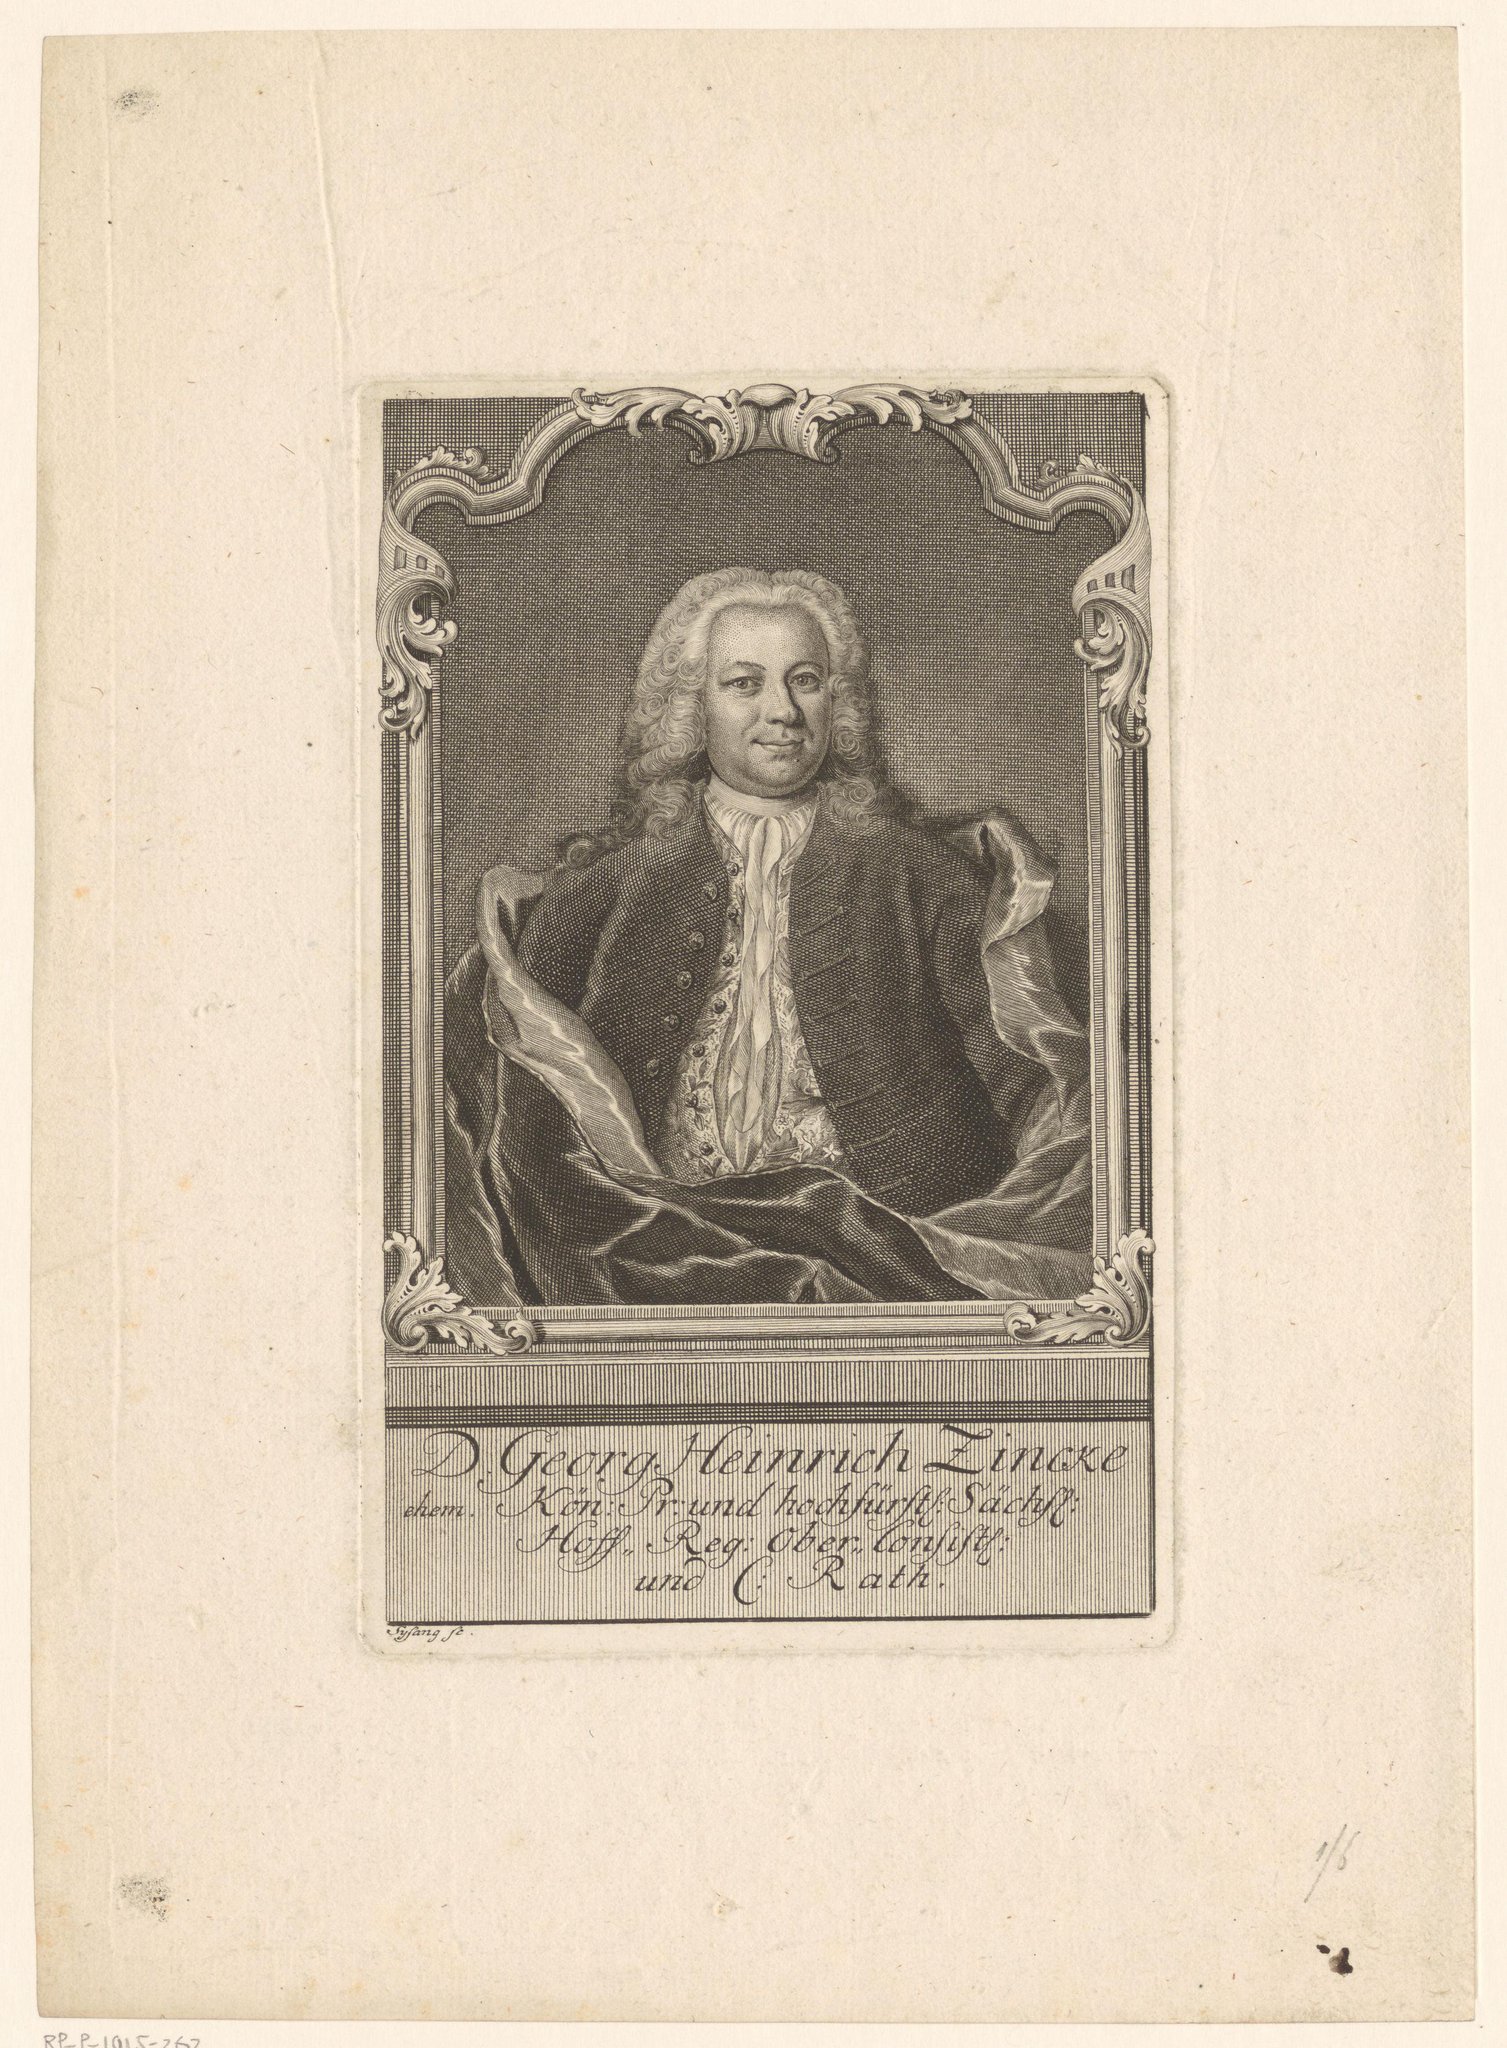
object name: print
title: Portret van Georg Heinrich Zincke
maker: johann christoph sysang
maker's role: print maker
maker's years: 1703-1757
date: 1731-1757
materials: paper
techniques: engraving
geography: germany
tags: historical persons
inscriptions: collector's mark: Lugt 2228, collector's mark: Lugt 358